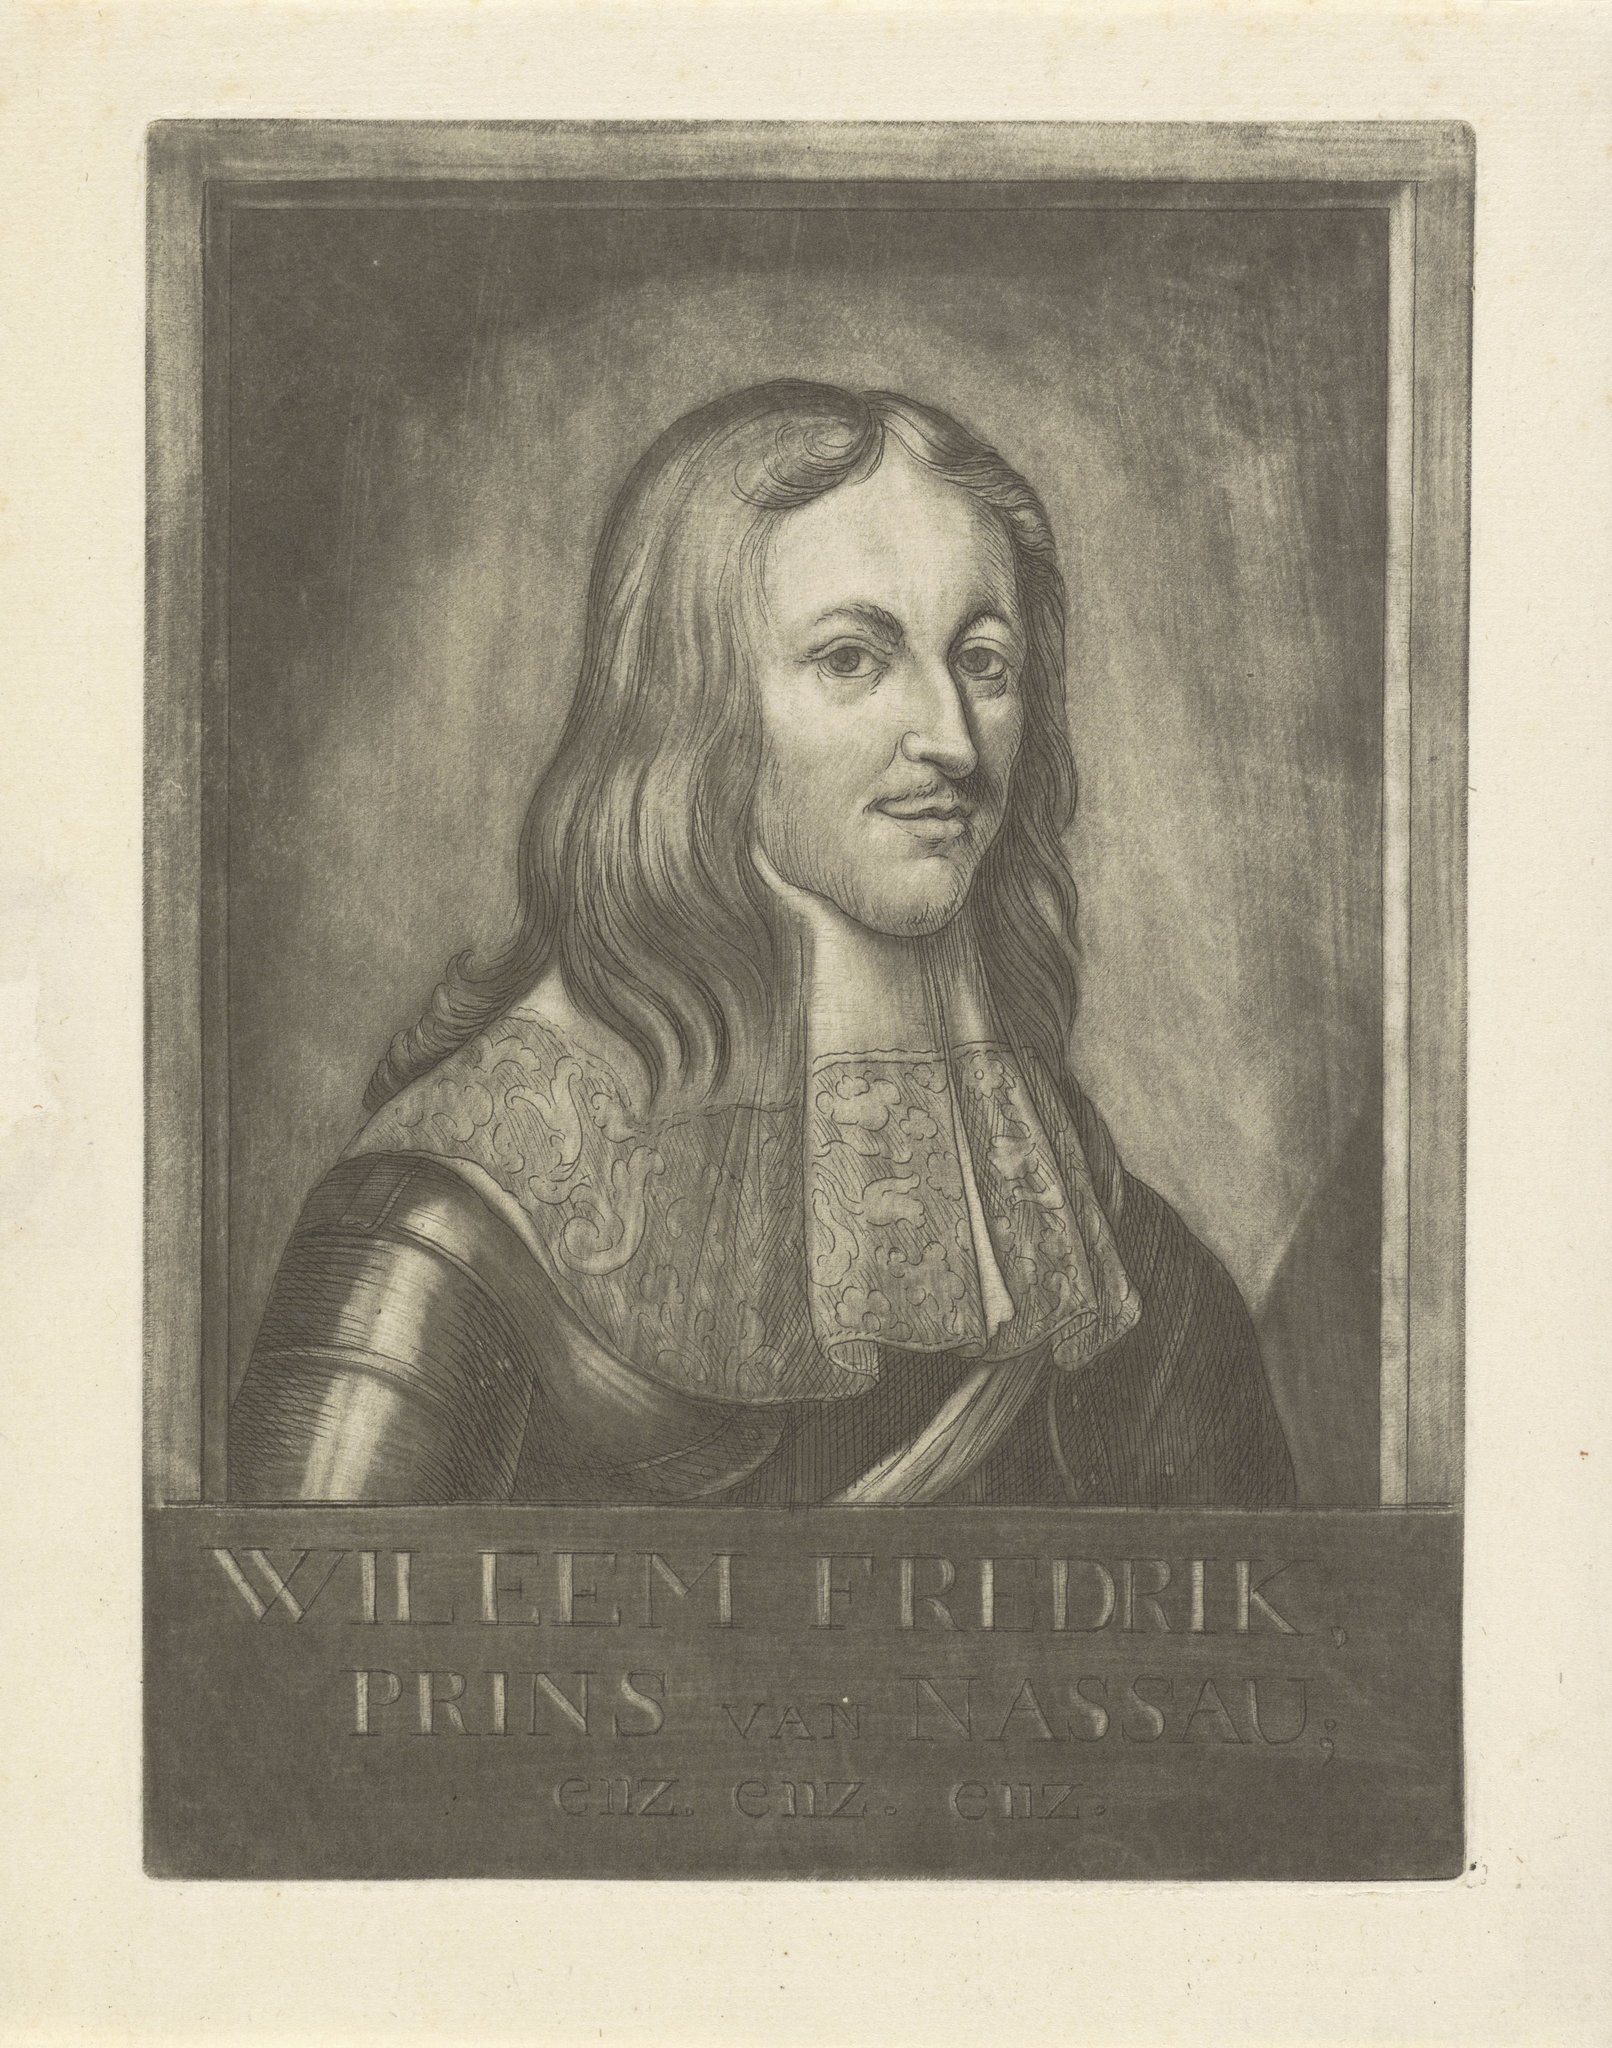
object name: book illustration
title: Portret van Willem Frederik, graaf van Nassau-Dietz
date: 1770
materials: paper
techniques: etching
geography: leeuwarden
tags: arnhem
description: De hier vermelde titel verwijst naar de hoogst verkregen titel van de geportretteerde, niet per se naar de titel die de geportretteerde op deze voorstelling draagt. Prent uit: Bosch, Johannes van den. De heeren stadhouderen van Vriesland, zedert den jare acht-hondert, volgens hoogst derzelver successie kortelyk beschreven. Leeuwarden: Abraham Ferwerda en Gerrit Tresling, 1770.